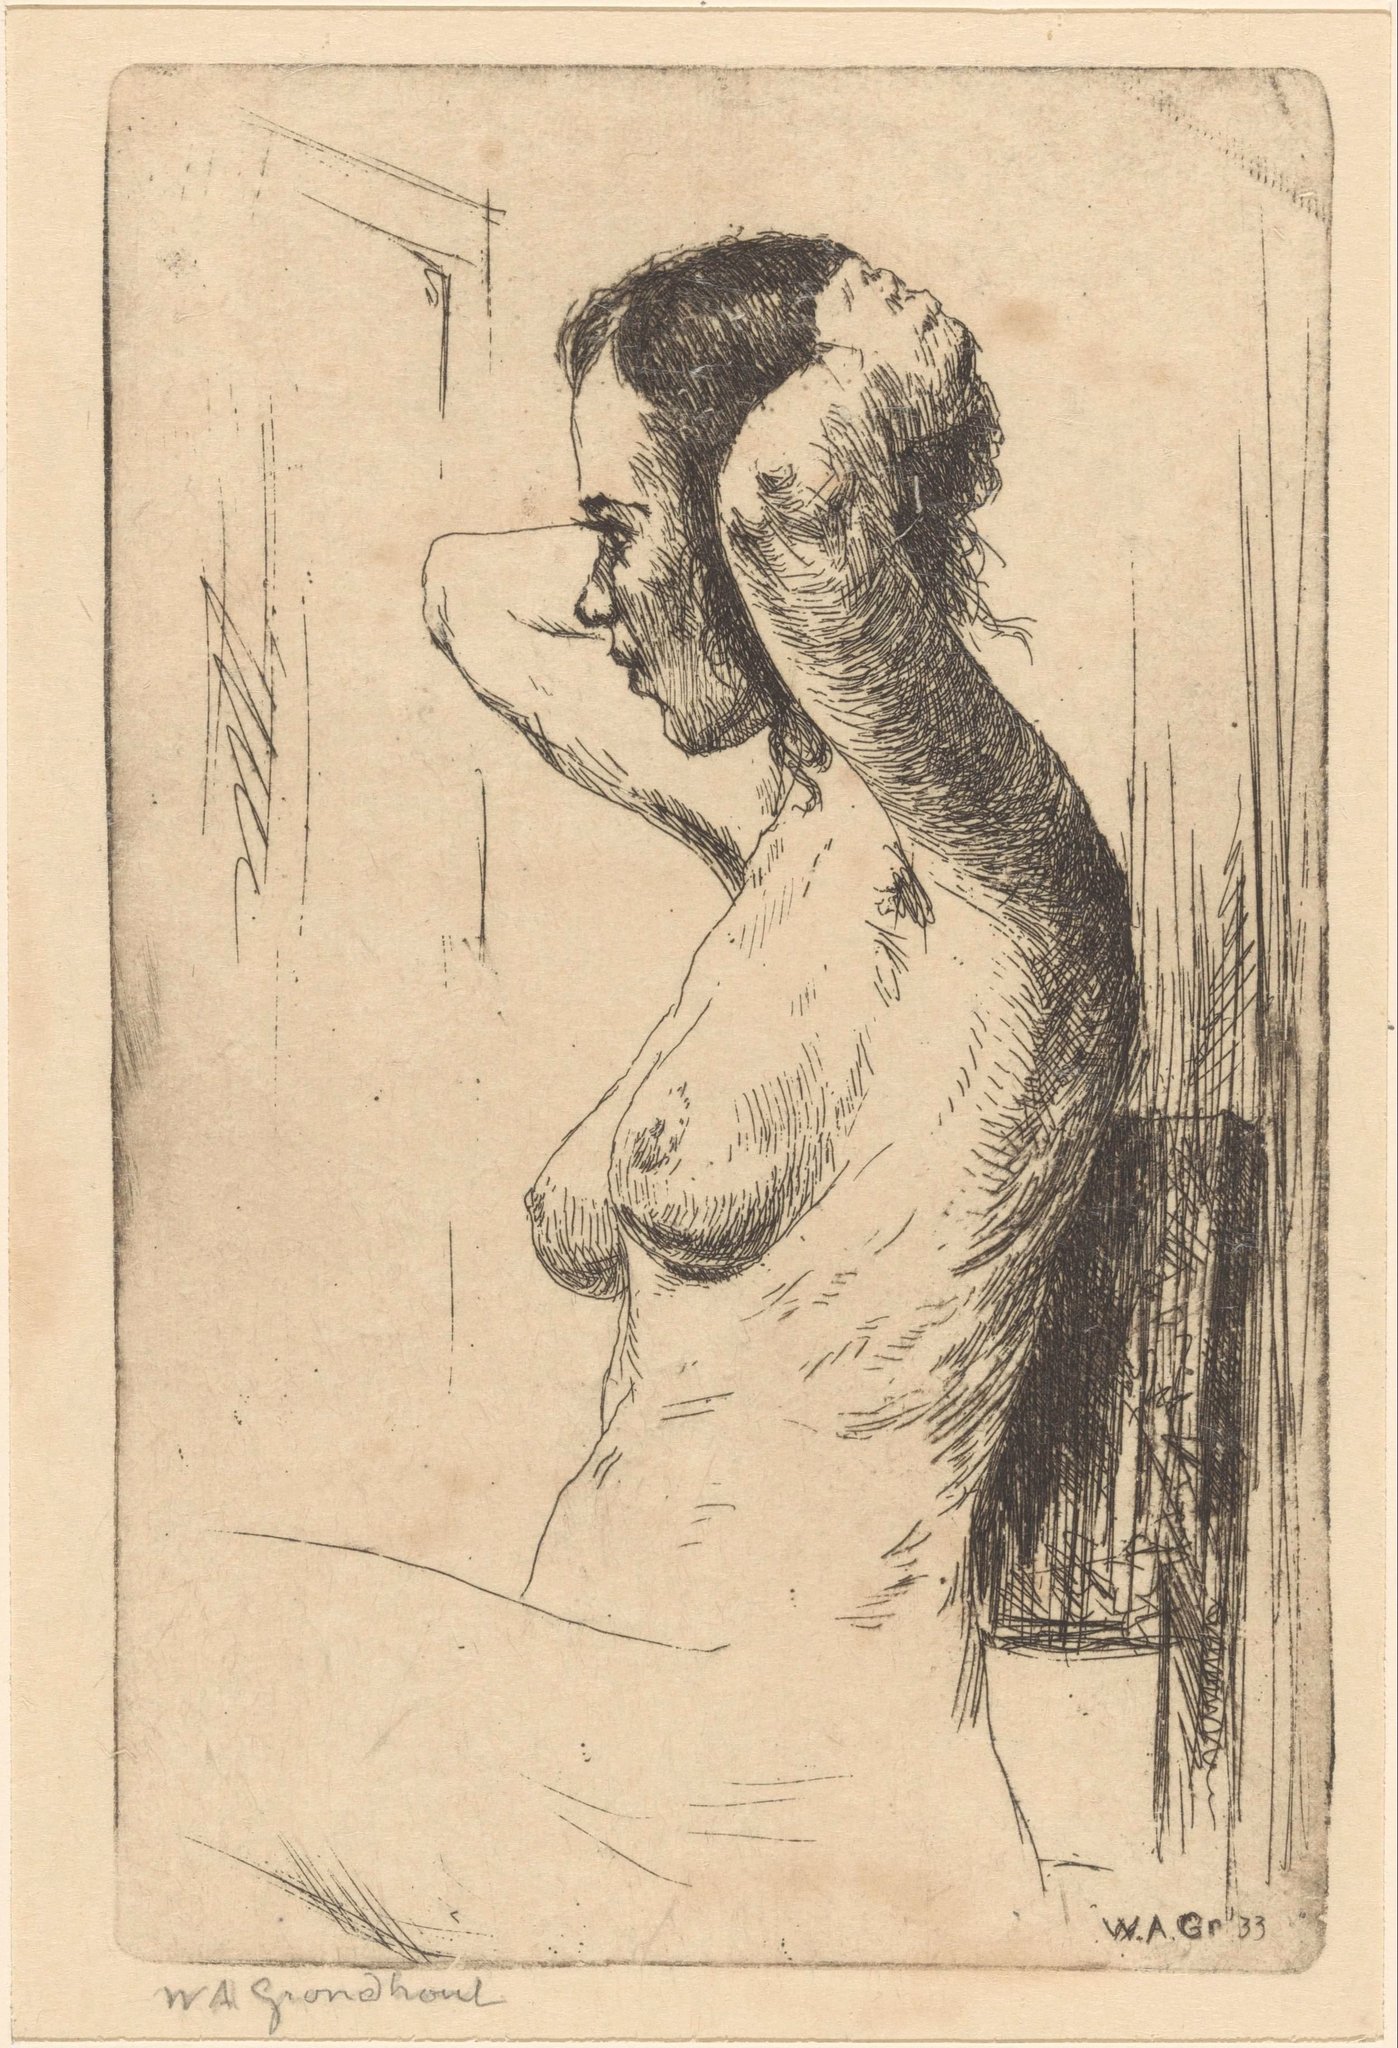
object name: print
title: Zittende, naakte vrouw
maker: willem adrianus grondhout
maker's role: draughtsman, painter, print maker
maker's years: 1878-1934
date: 1933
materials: paper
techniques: etching, intaglio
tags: hand behind the head - aa - both arms or hands, woman (showing herself) undressed, quasi-nude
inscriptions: collector's mark: Lugt 2228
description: De vrouw raakt haar achterhoofd aan met beide handen.